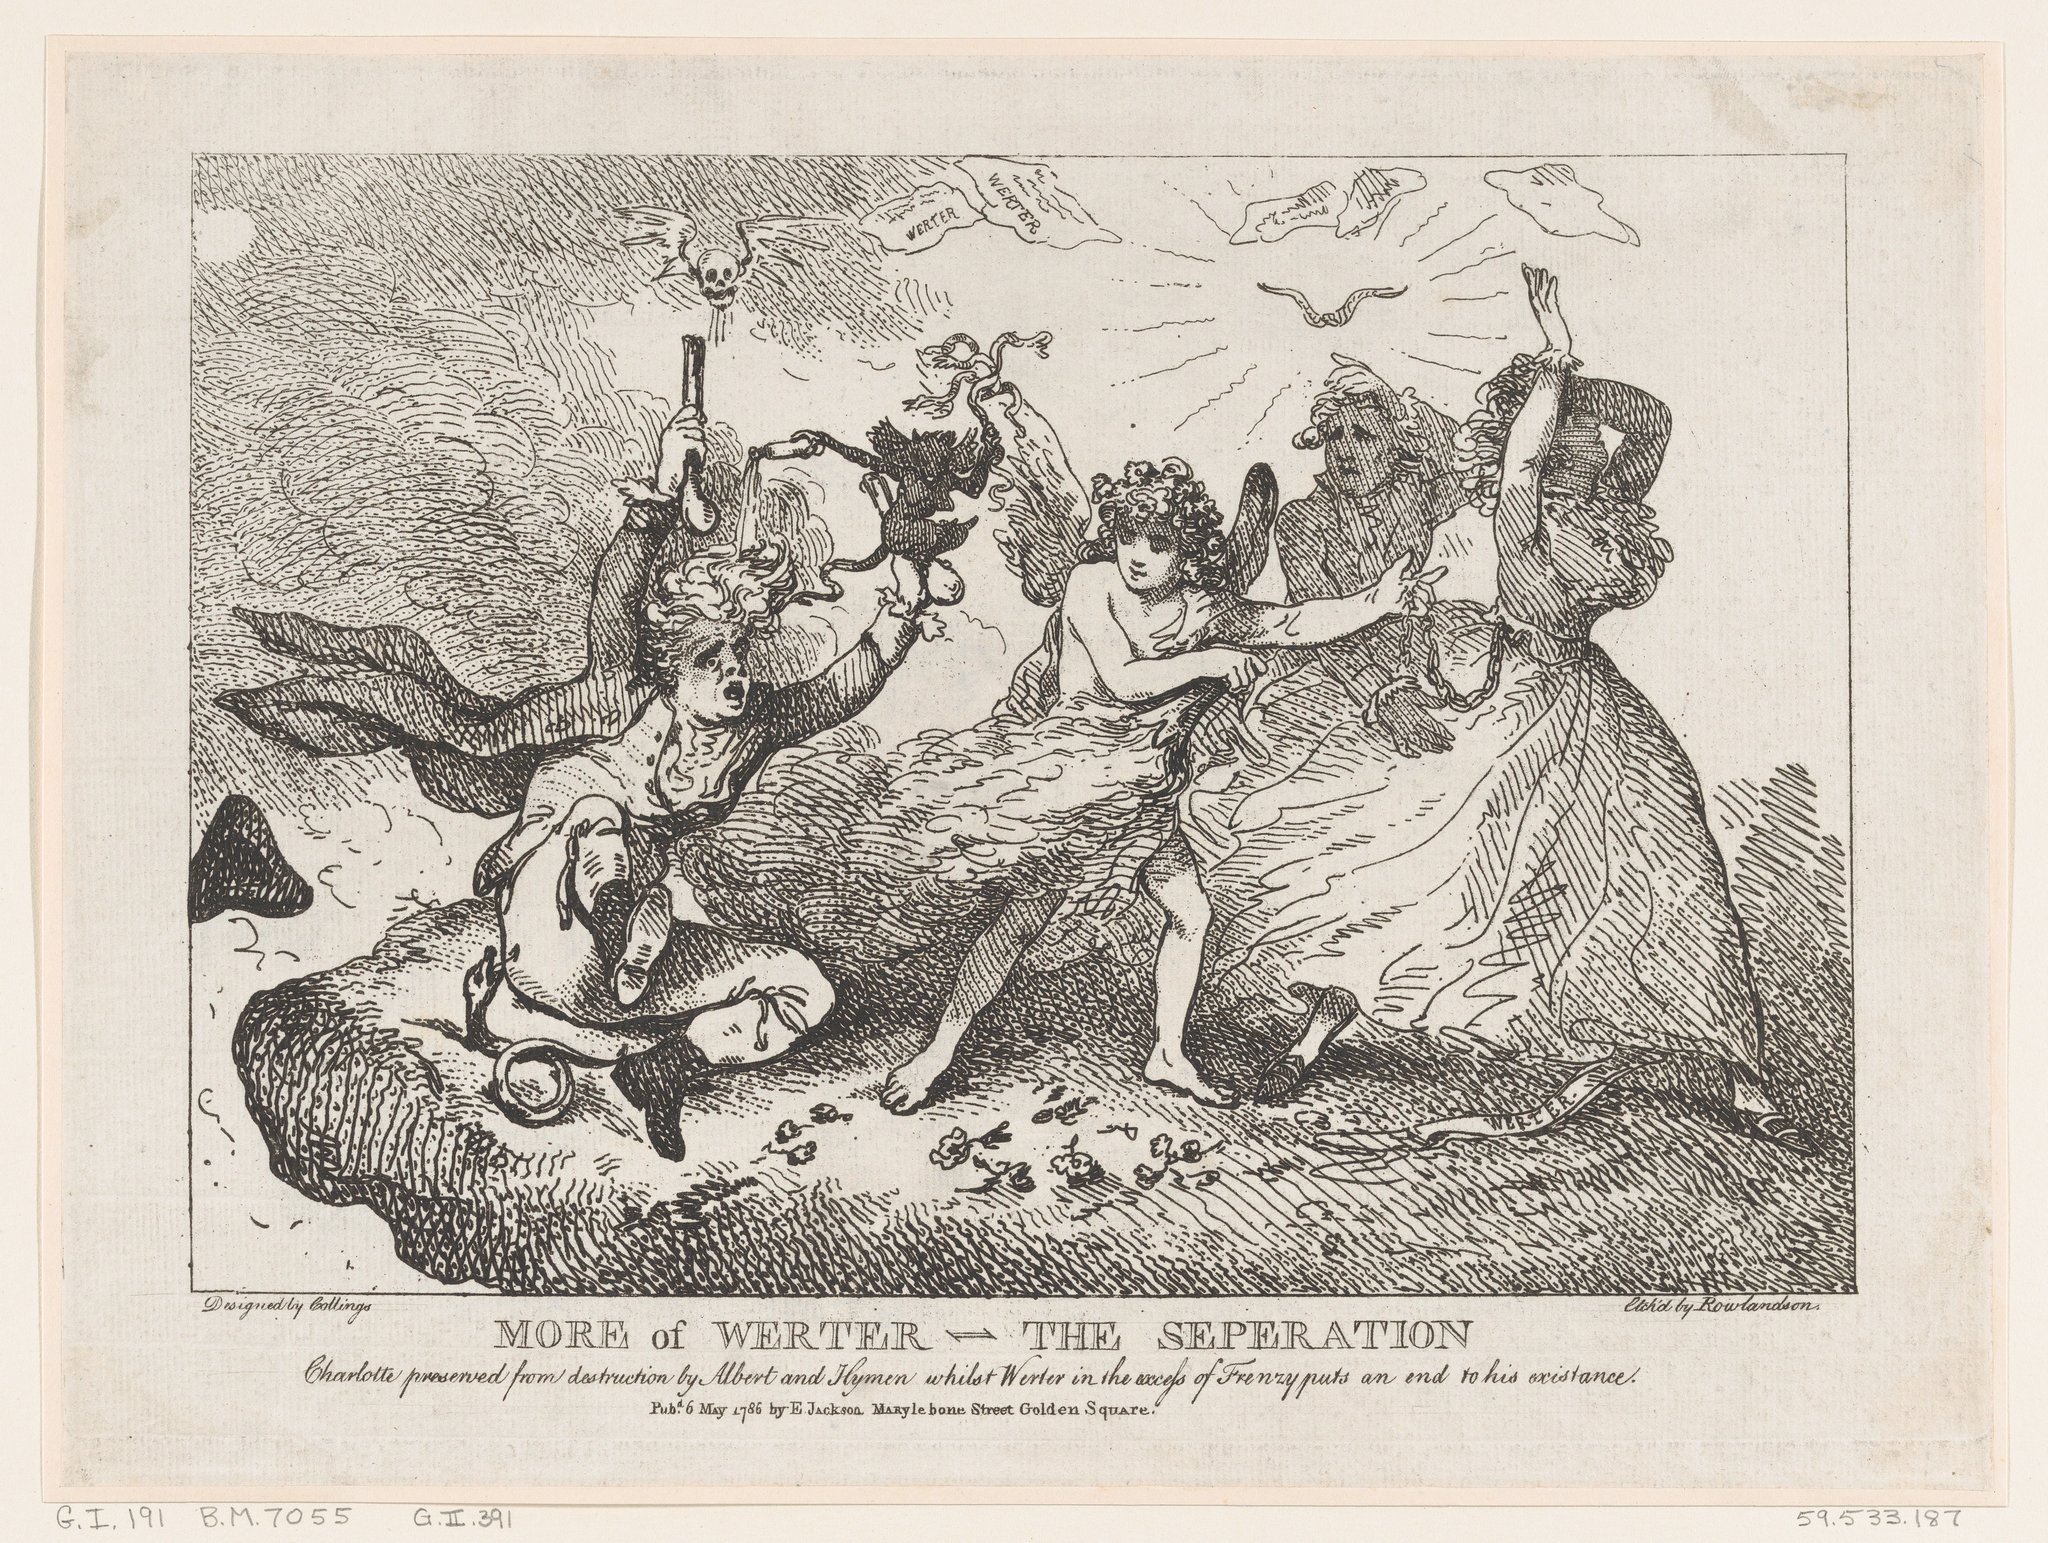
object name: print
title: More of Werther–The Separation: Charlotte Preserved from Destruction by Albert and Hymen, whilst Werther in an access of frenzy puts and end to his existence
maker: thomas rowlandson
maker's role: artist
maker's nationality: british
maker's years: 1757-1827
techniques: etching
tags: men,women